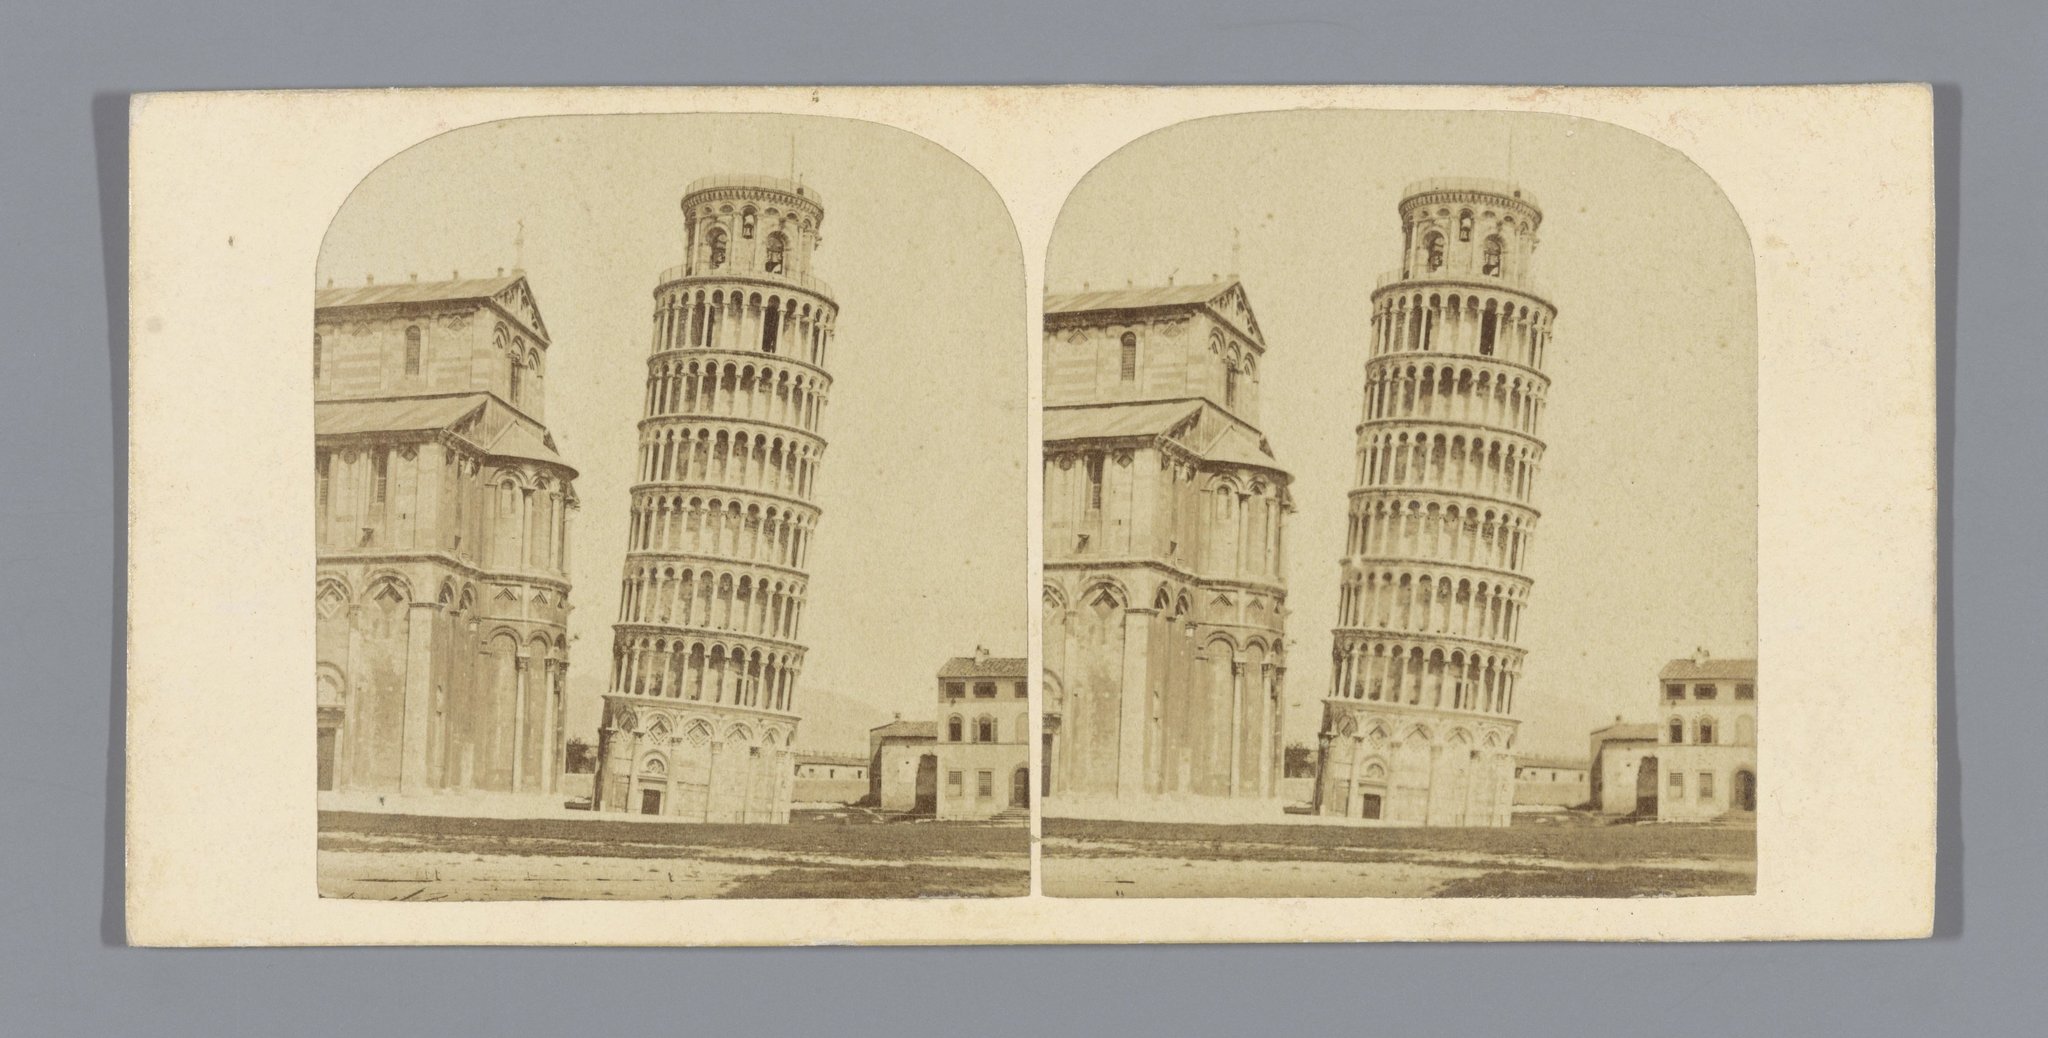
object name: stereograph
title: Exterieur van de Toren van Pisa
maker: Anonymous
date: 1850-1880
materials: cardboard, photographic support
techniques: albumen print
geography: pisa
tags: parts of church exterior and annexes: campanile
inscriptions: number: ‘N: 1.’, inscription: ‘La Tour penchée à Pise’